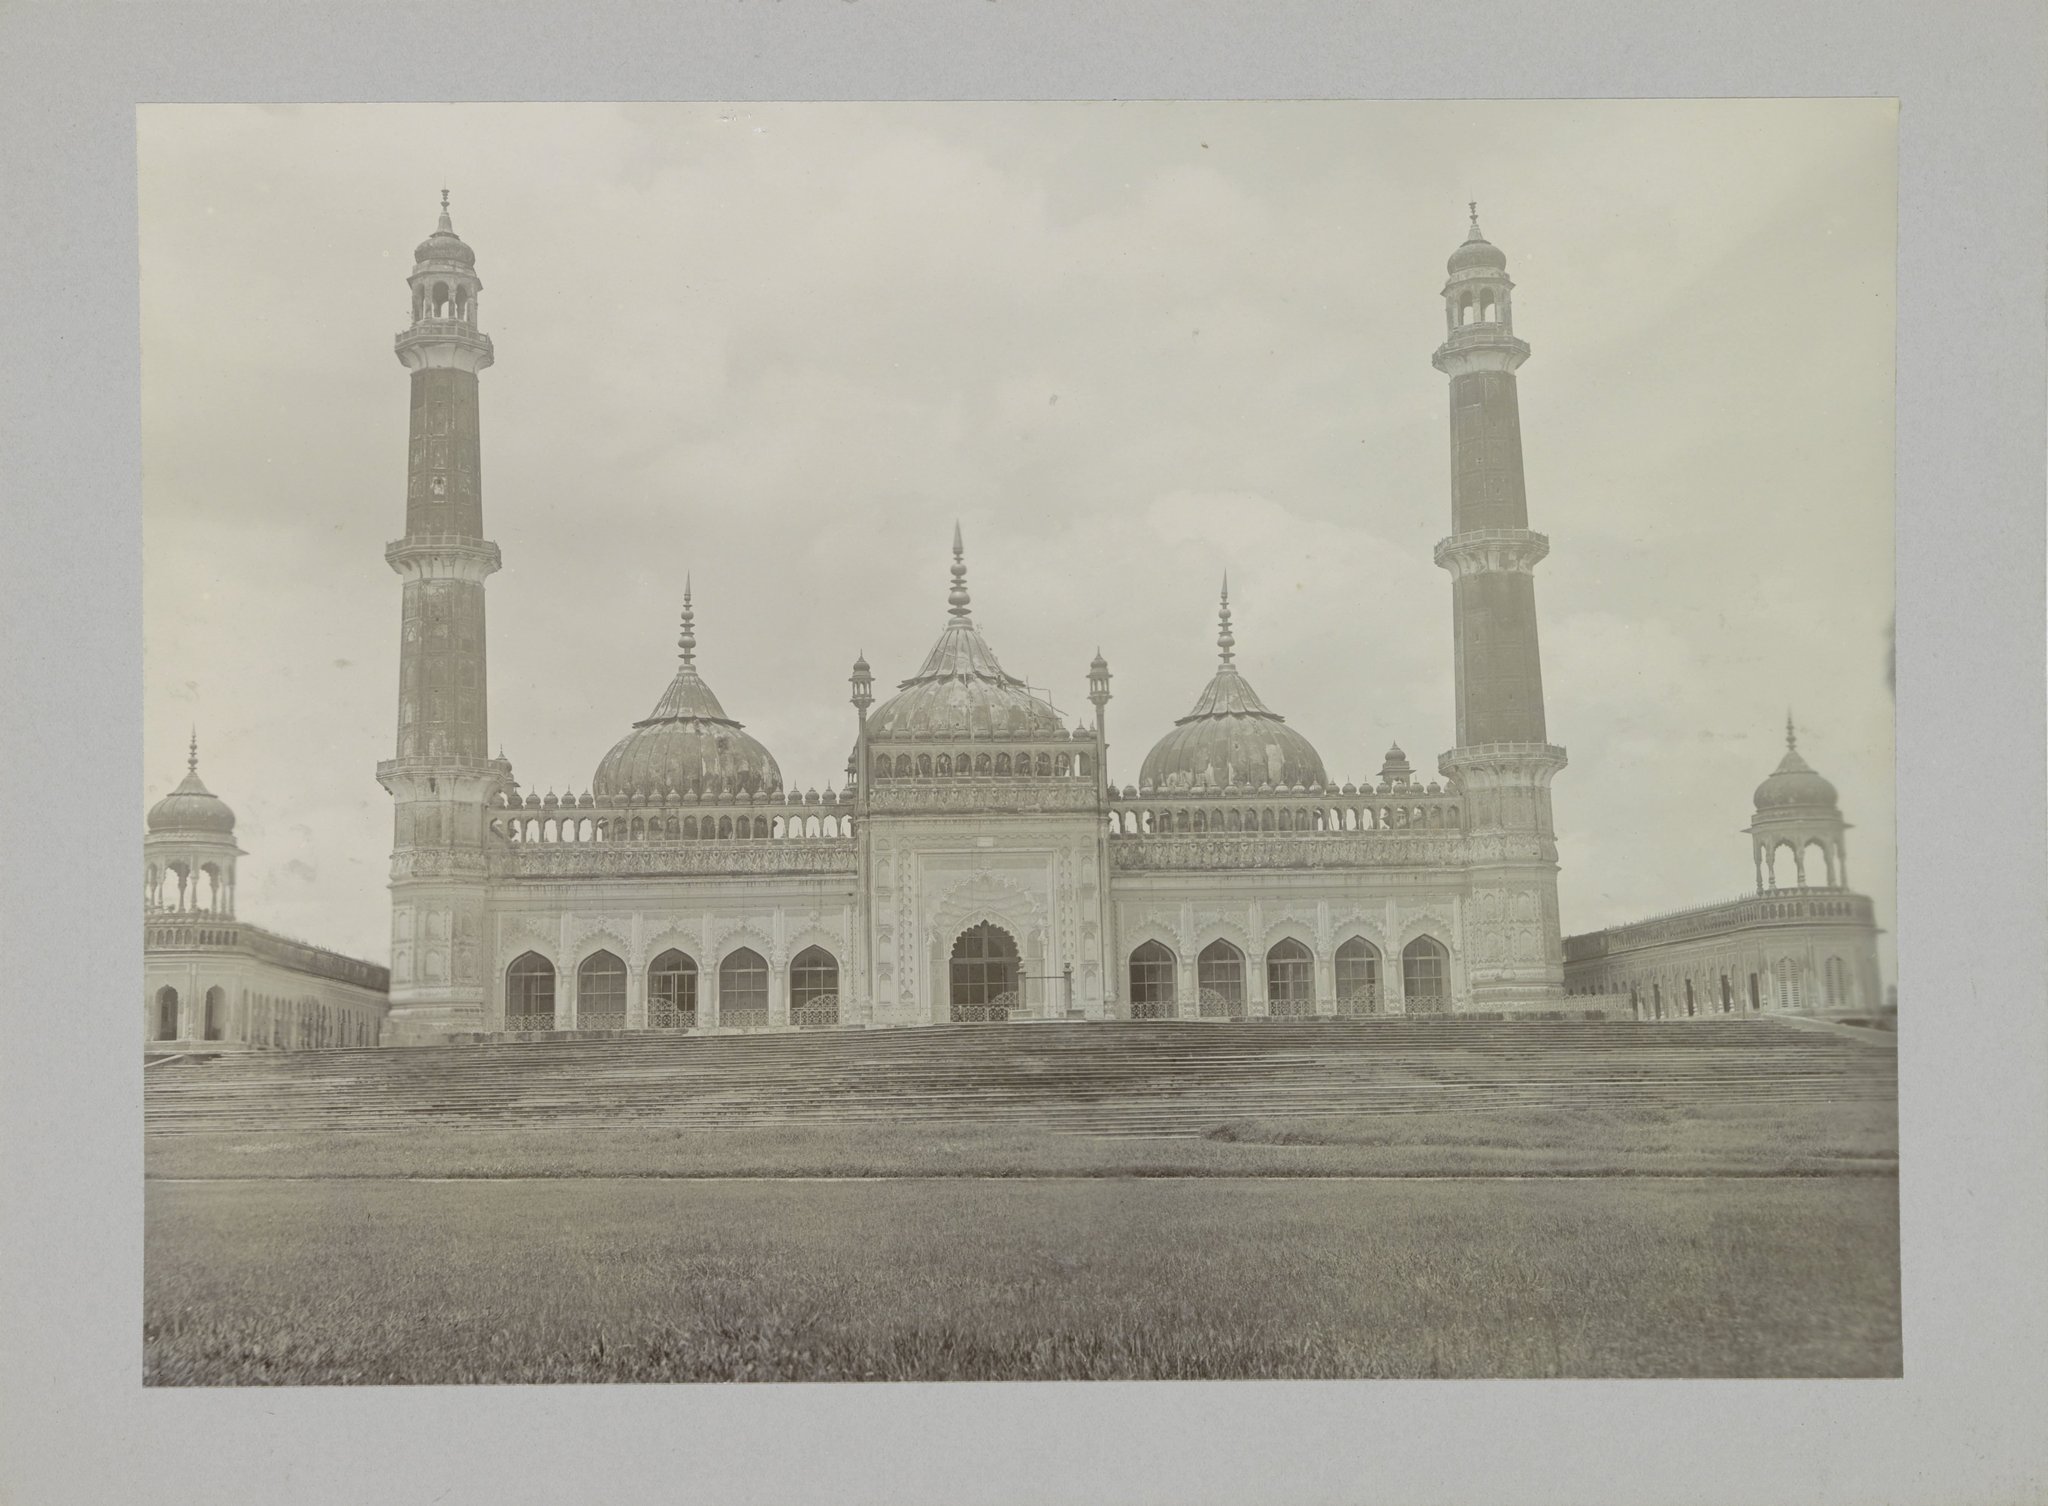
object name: photograph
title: View of a mosque at Lucknow, Uttar Pradesh, India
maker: Anonymous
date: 1895-1915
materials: cardboard, paper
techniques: gelatin silver print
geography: lucknow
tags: lucknow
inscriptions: annotation: ‘15. Moskee te Lucknow.’